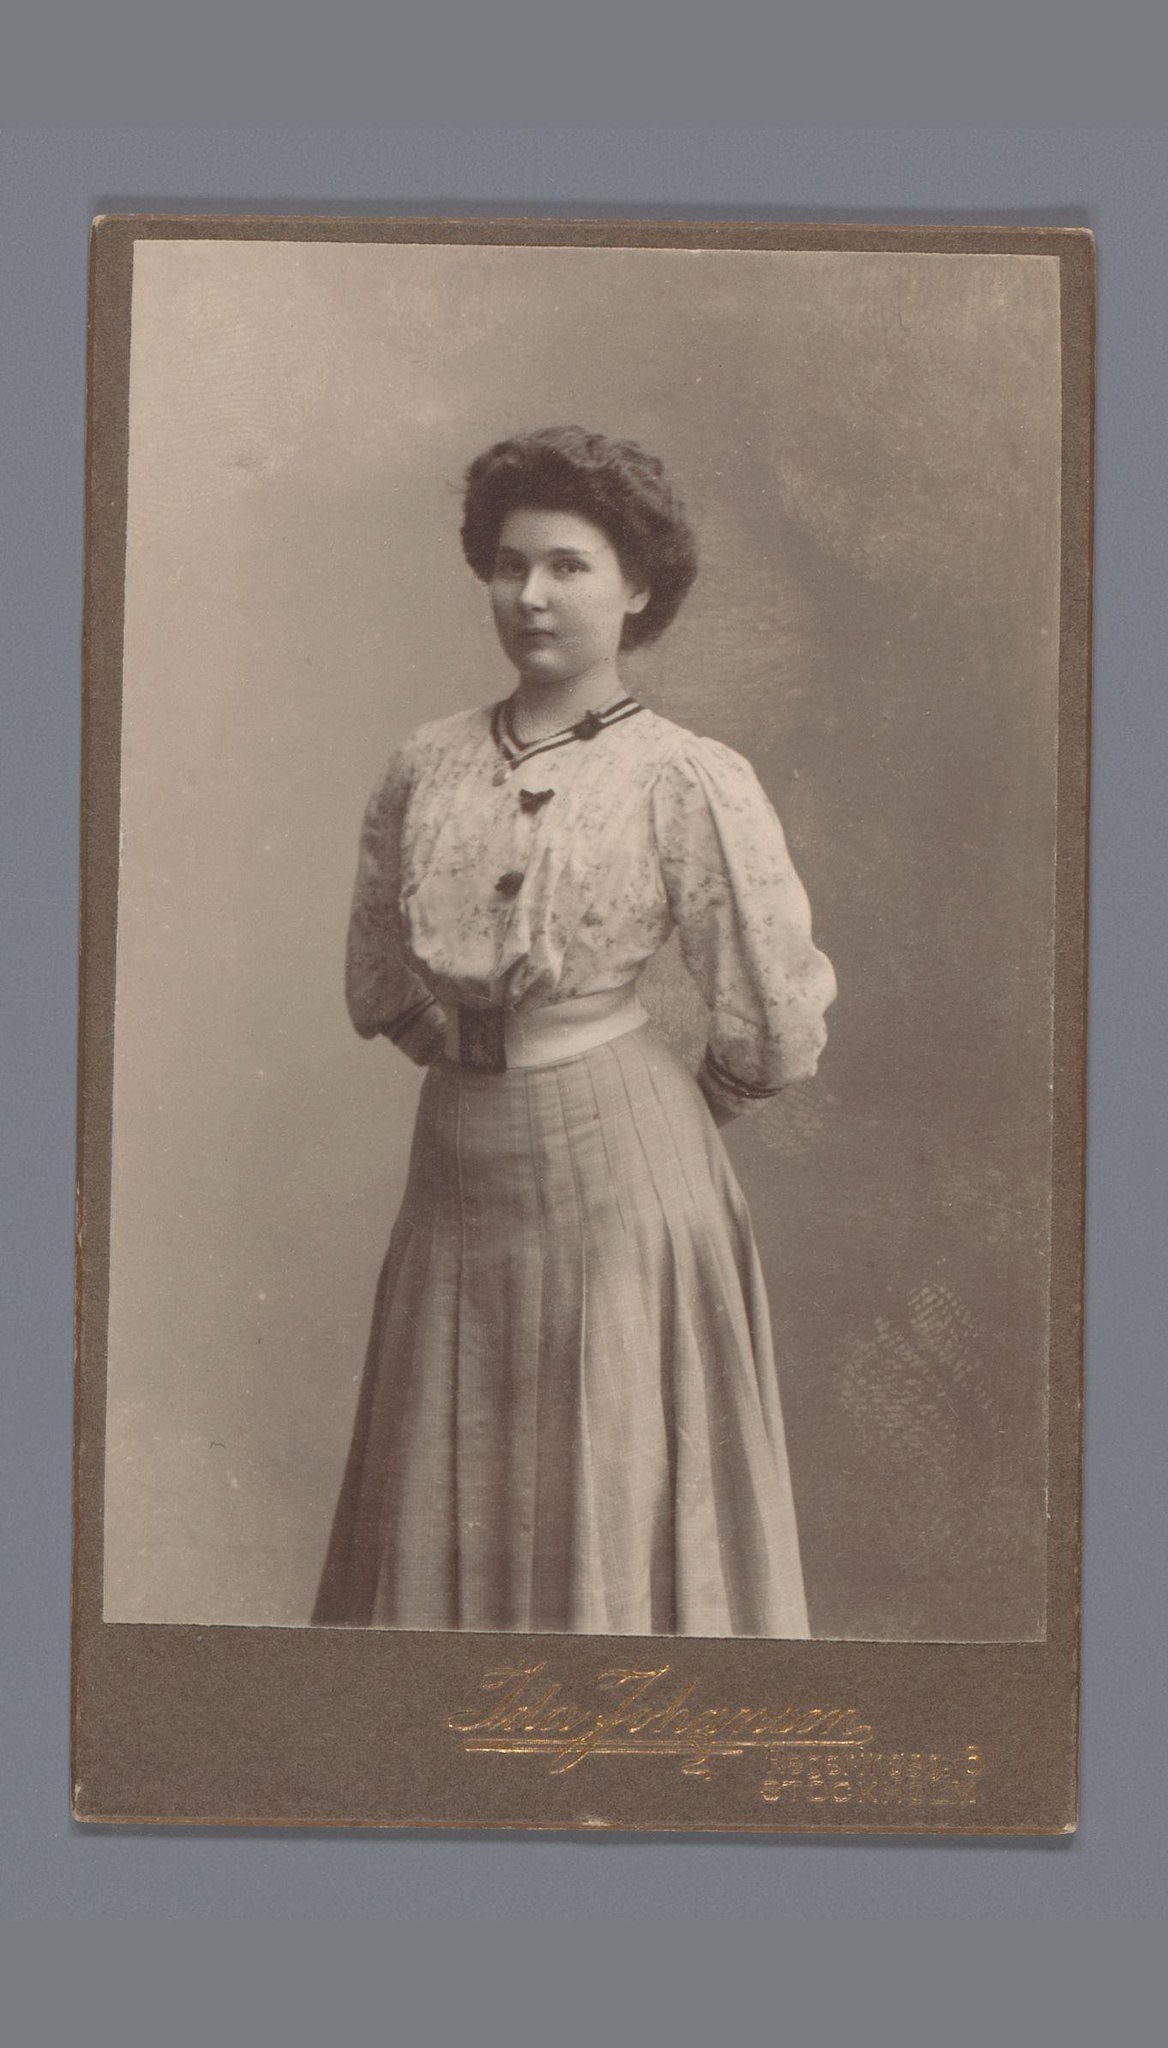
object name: carte de visite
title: Portret van een onbekende vrouw, aangeduid als Thyra Stroberg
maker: ida johanson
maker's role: fotograaf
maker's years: 1863-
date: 1910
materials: cardboard, photographic support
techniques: matte daylight collodion silver print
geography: stockholm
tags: adolescent, young woman, maiden, historical persons - bb - woman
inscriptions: inscription: ‘Thyra Ströberg/ 27.3.1910’, address: ‘Ida Johanson/ Regeringsg. 6/ STOCKHOLM’